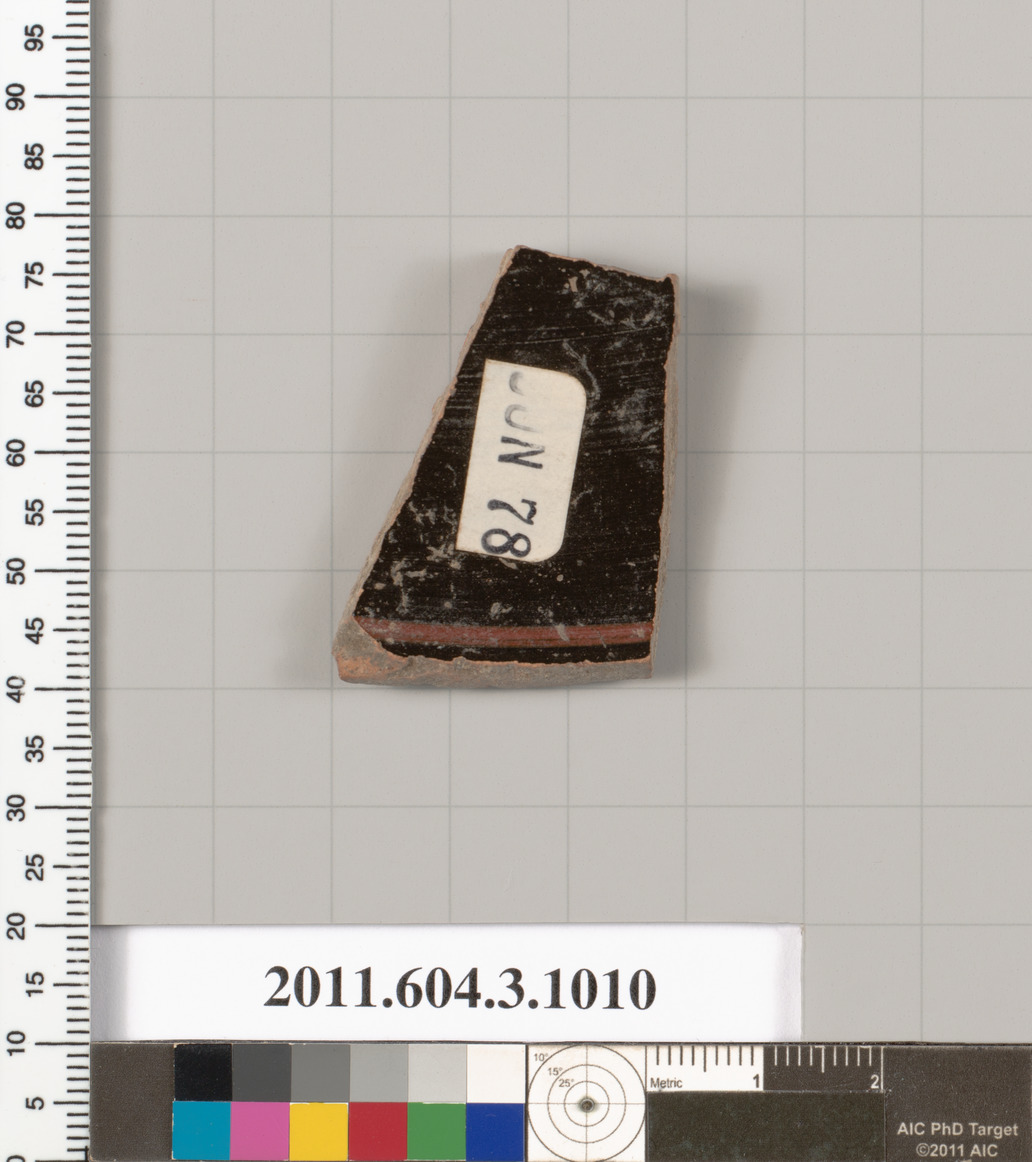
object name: lekanis fragment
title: Terracotta fragment of a lekanis (covered dish)?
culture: greek, attic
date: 600-501 BCE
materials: terracotta